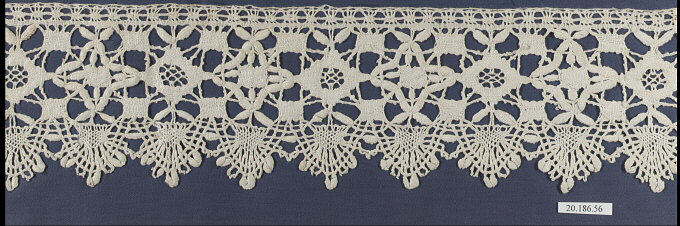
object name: edging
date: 1601-1700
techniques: lace